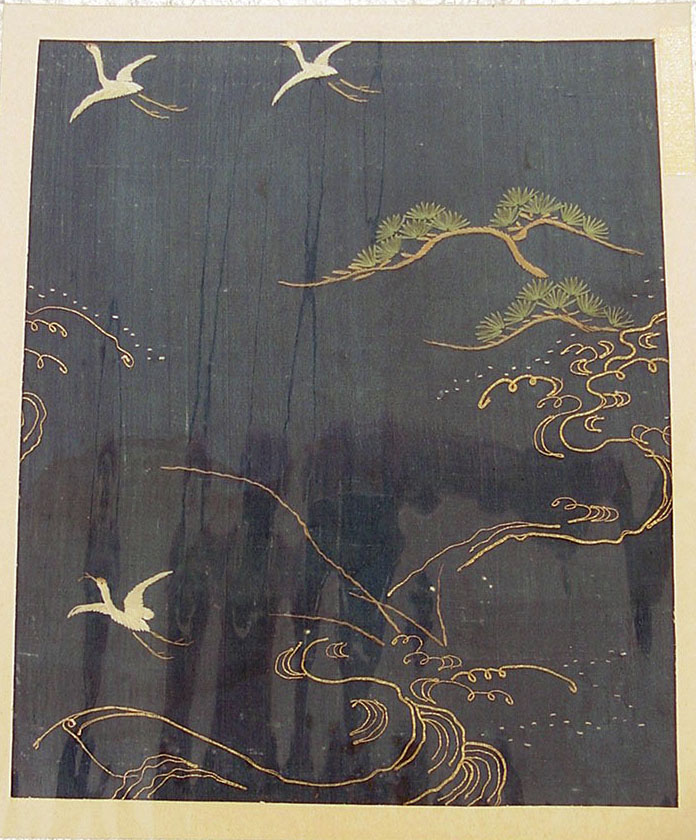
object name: piece from a kosode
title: Piece from a Kosode with Cranes, Pines, and Waves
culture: japanese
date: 1615-1868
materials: metal thread, silk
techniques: embroidery, weave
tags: cranes,trees,waves